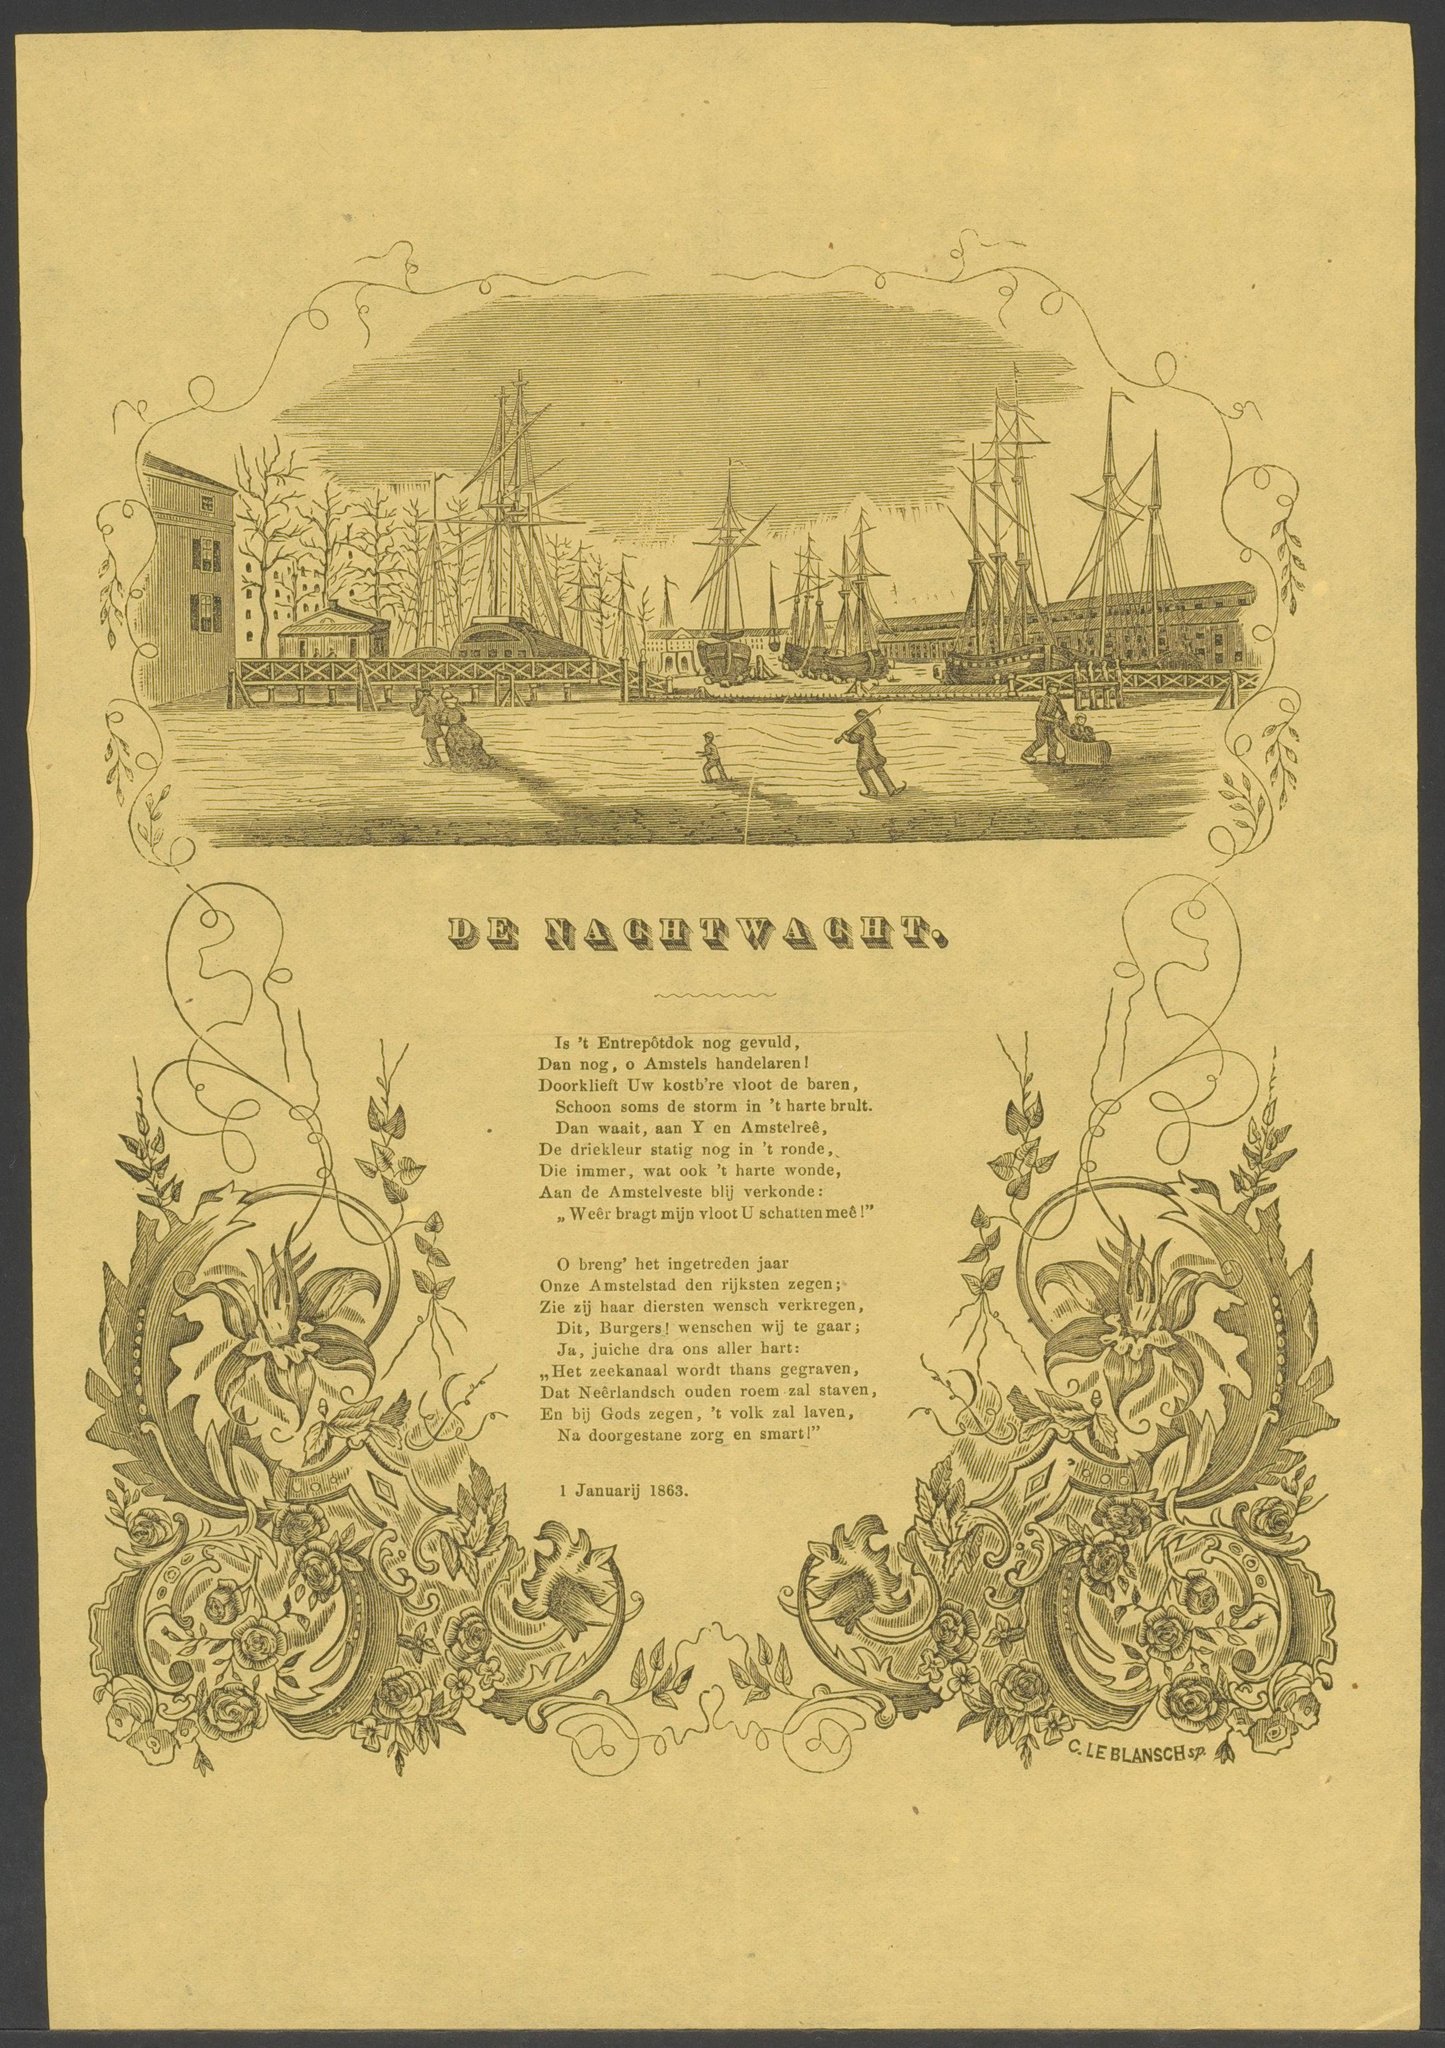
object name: print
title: De Nachtwacht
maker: christiaan le blansch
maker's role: print maker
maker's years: 1827-1886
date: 1862-1863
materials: paper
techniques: letterpress printing, engraving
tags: night patrol, floral interlace ~ ornament, skates (winter sports), amsterdam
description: Nieuwjaarswens van de Amsterdamse nachtwacht (ratelwacht), 1863. Centraal een gedicht, daarboven een gezicht op schaatsende mensen voor een scheepswerf te Amsterdam. Onderwerpsrubrieken binnen de Atlas Zeden en Gewoonten: Zeden en gewoonten in engeren zin, Volksleven, Volksbladen, Nieuwjaars- en Kerstwenschen, Amsterdam.